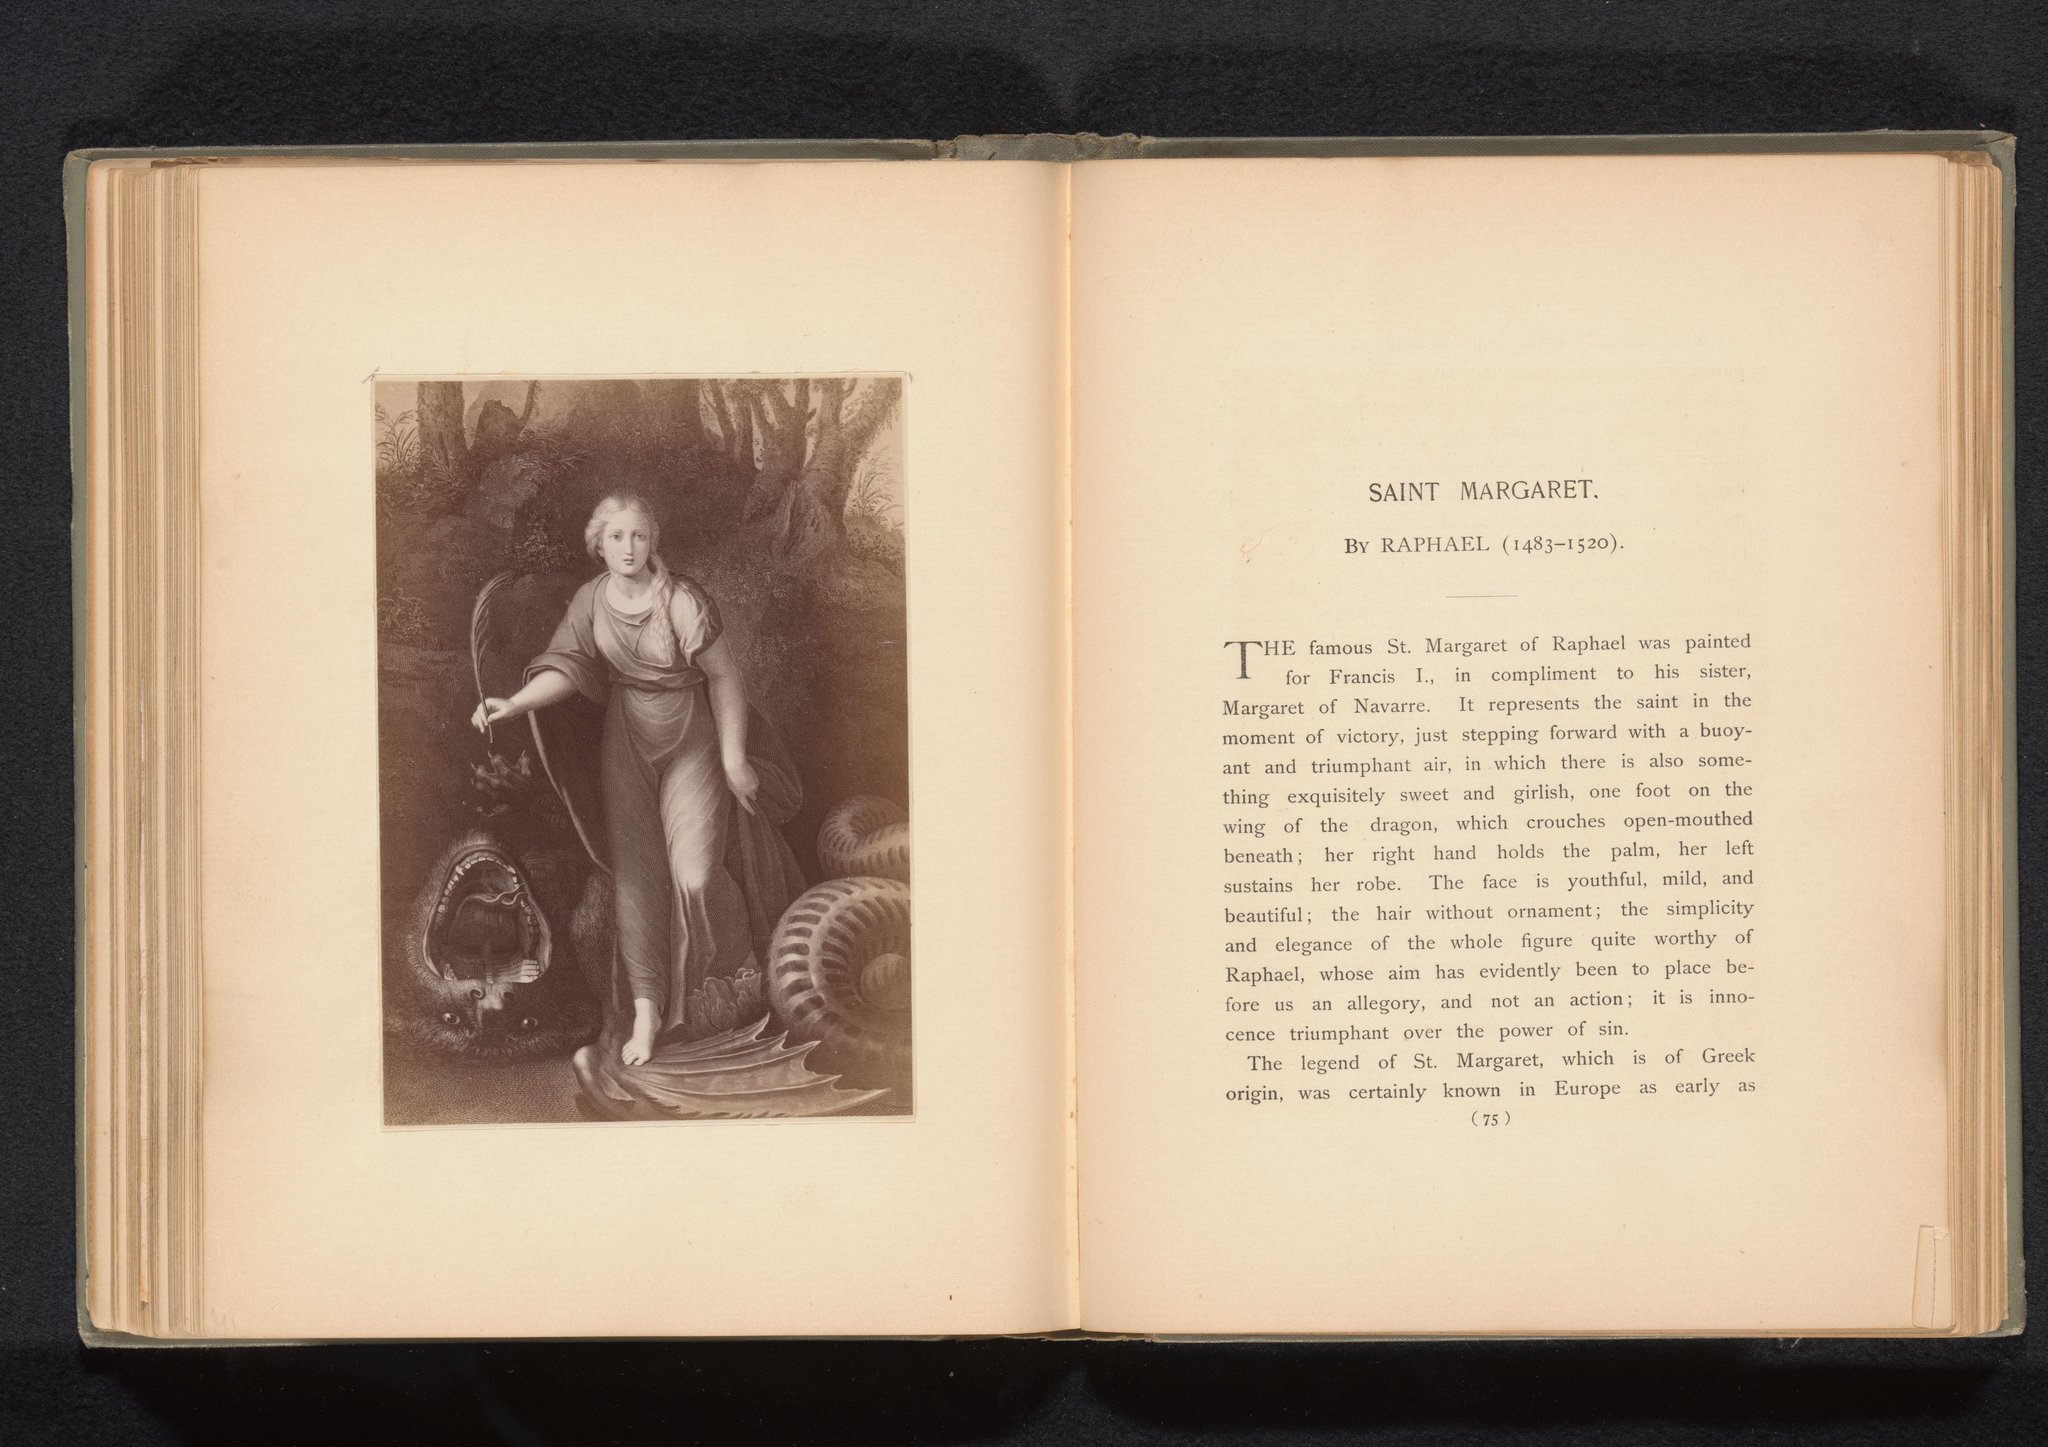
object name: page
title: Fotoreproductie van een prent naar een schilderij, voorstellende de heilige Margaretha van Antiochië en de draak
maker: Anonymous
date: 1882-1887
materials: photographic support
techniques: albumen print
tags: st. margaret in her dungeon is swallowed by a dragon (satan)